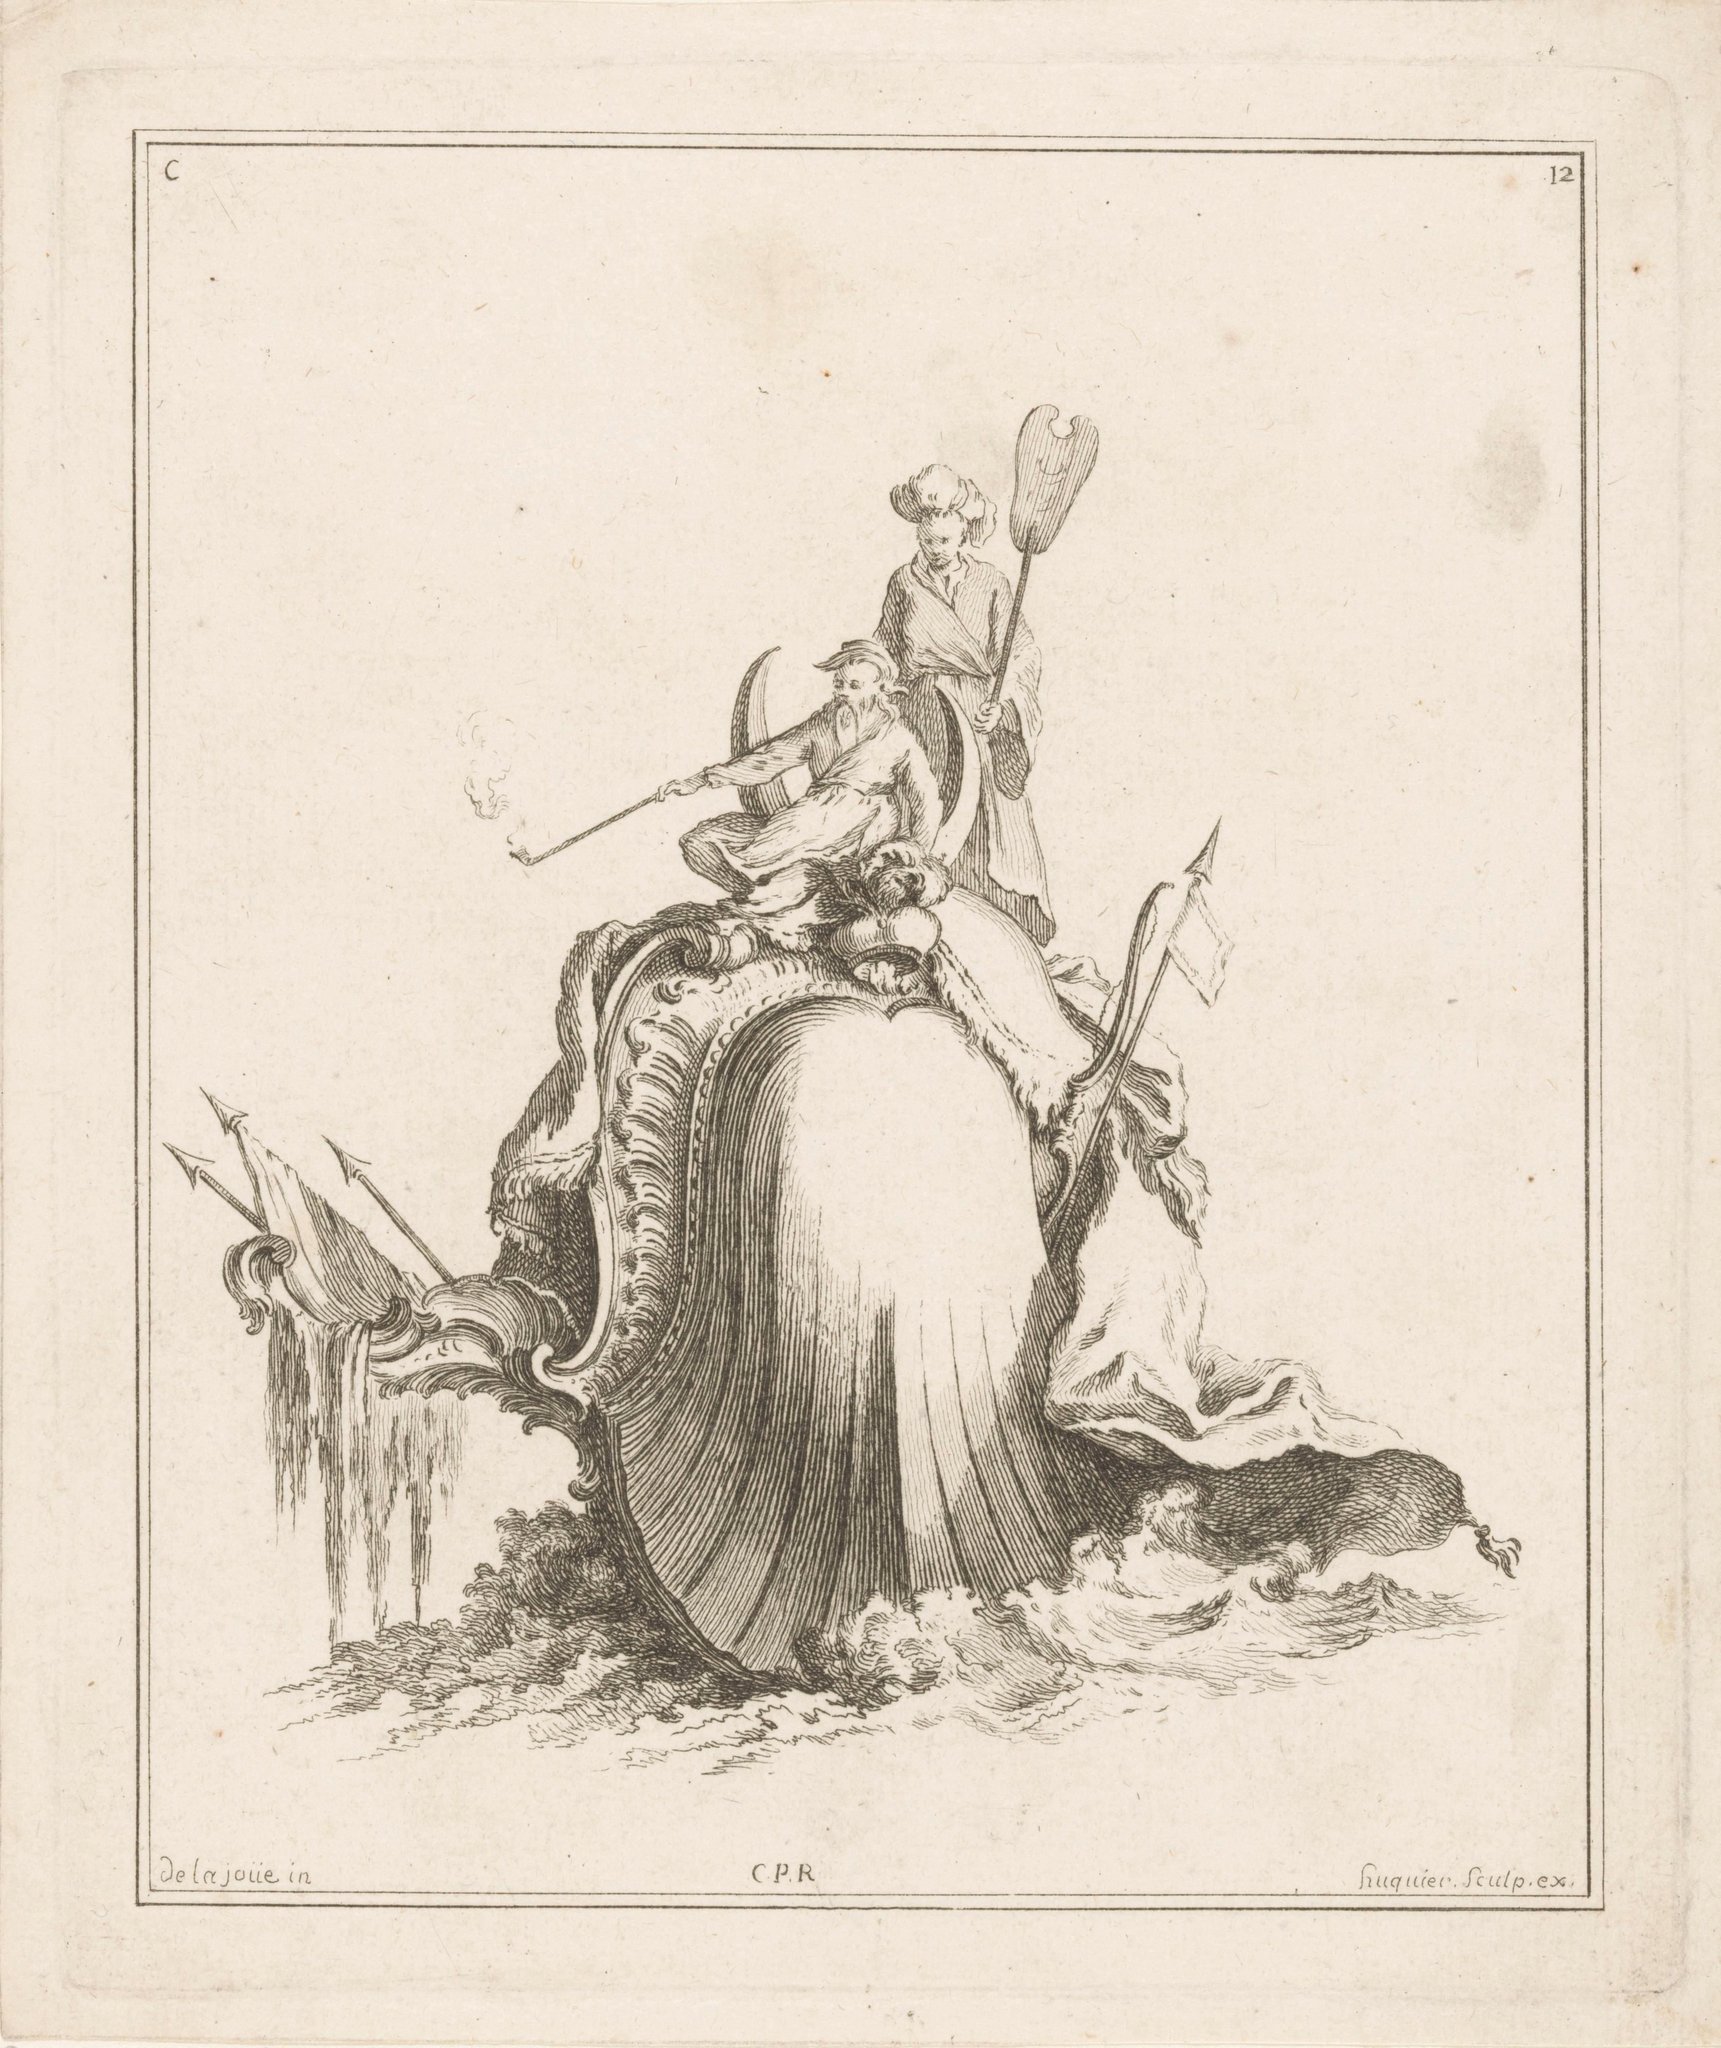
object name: print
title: C Troisieme Livre De Cartouches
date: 1705-1761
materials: paper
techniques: etching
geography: paris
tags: the (nude) human figure; 'corpo humano' (ripa), ornament ~ cartouche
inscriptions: collector's mark: Lugt 2760, collector's mark: Lugt 2228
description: Bovenop een cartouche zit een man met een lange pijp op een halve maan. Rechts van hem staat een man met een waaier. Links en rechts van de cartouche een boog en speren.